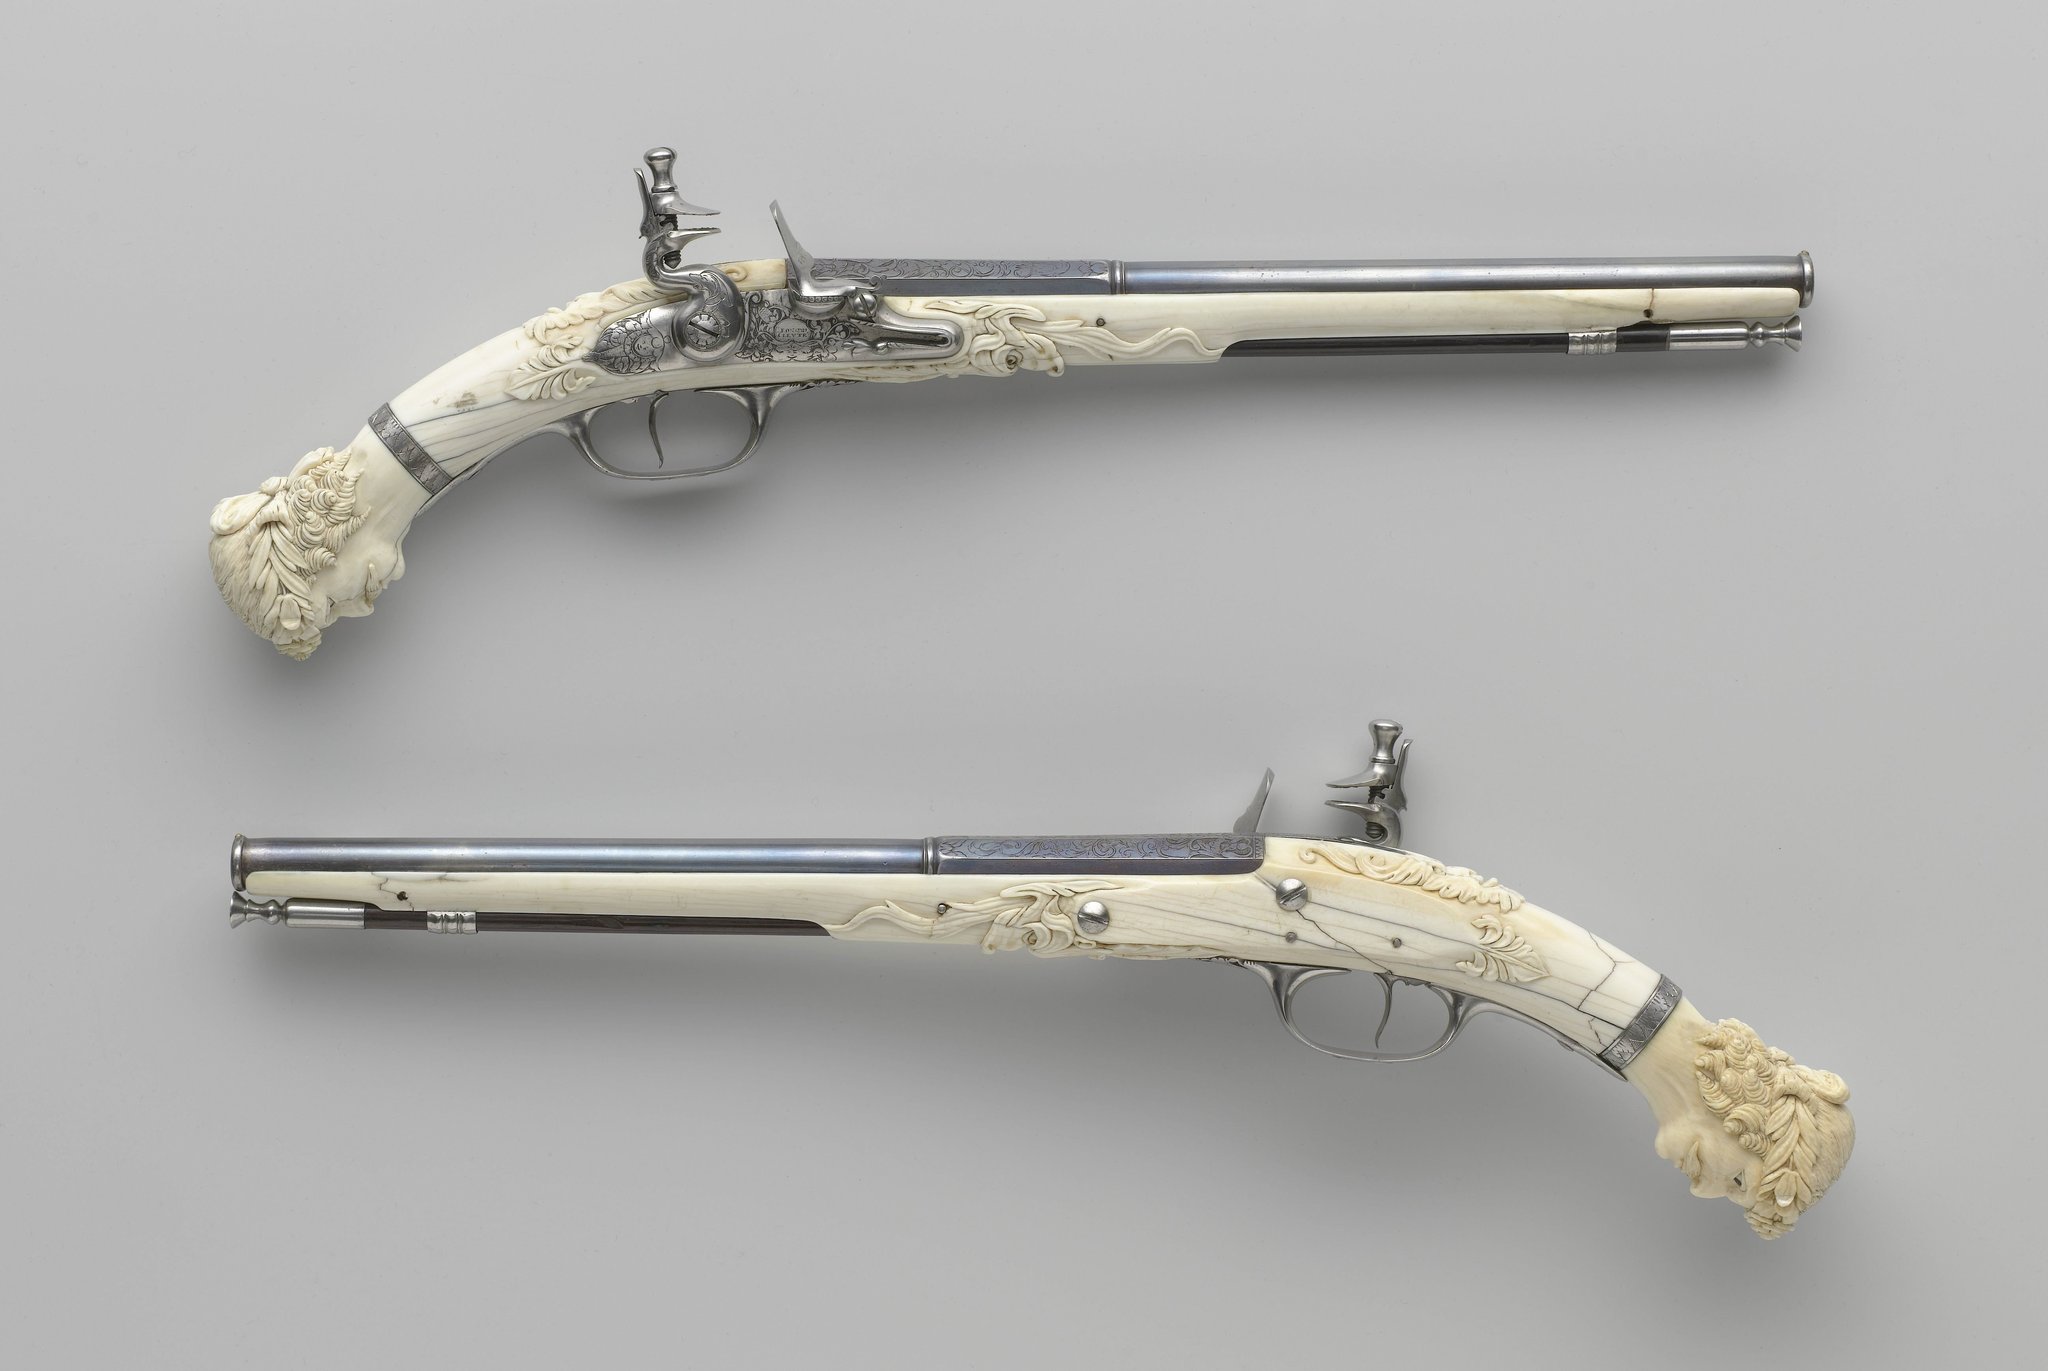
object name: flintlock pistol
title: Pair of flintlock pistols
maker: leonard cleuter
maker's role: geweermaker, pistoolmaker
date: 1660-1664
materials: wood, gold, iron, ivory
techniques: cutting, engraving, striking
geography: maastricht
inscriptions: signature: ‘LEONARD // CLEVTEr’, : ‘N 125’, mark: ‘C.MIL. (St. 2260)’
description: Leonard Cleuter was an adventurer and a mercenary who occasionally tried to make money from the firearms trade. He signed this brace of pistols, the pommels of which are carved in the form of Classical warrior heads crowned with laurel wreaths. When Cleuter was declared bankrupt as an arms dealer in 1664, he left Maastricht and borrowed money to start his own regiment.